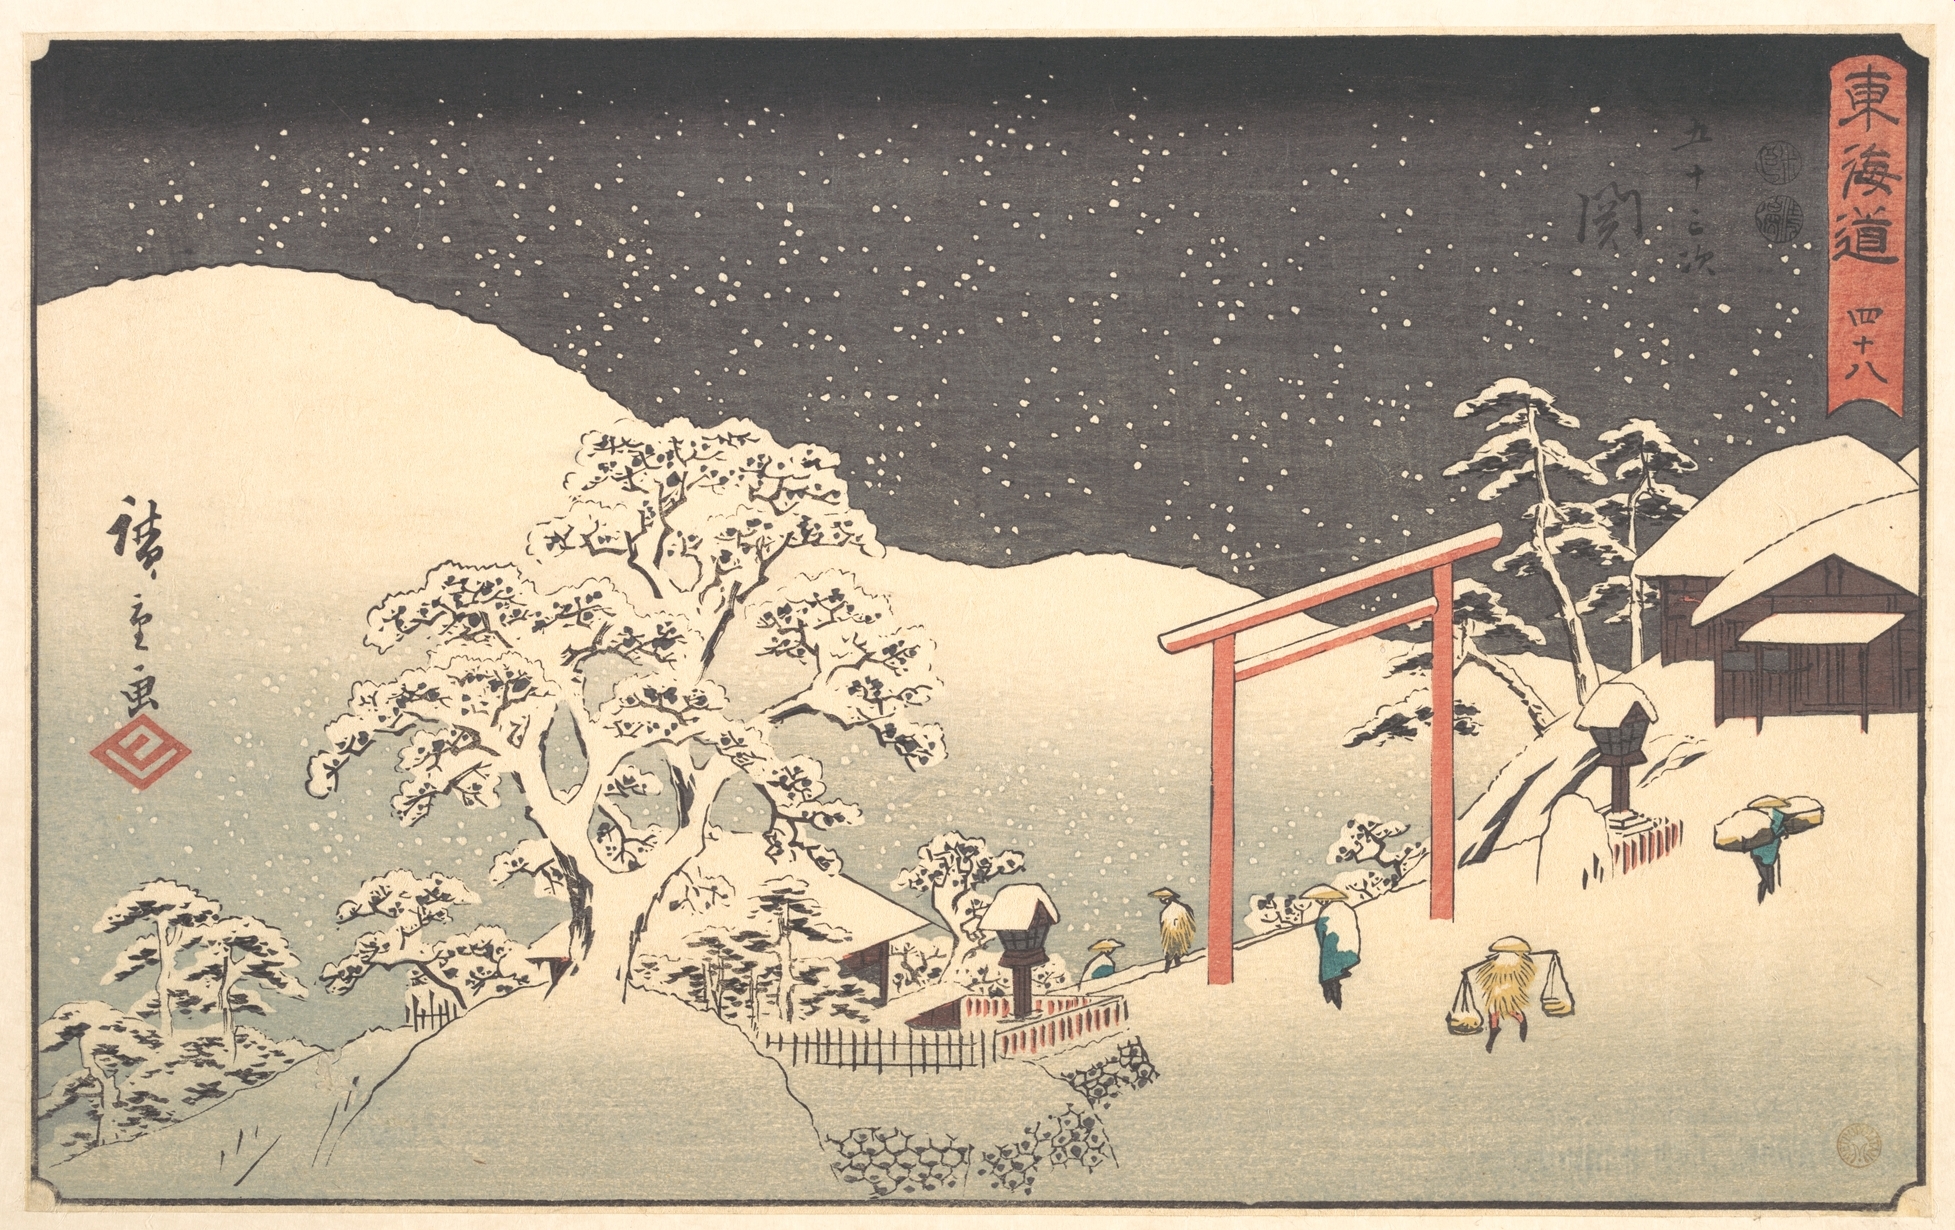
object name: print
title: Seki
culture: japanese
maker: utagawa hiroshige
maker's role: artist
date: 1848-1849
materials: ink, paper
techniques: woodblock print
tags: gates,landscapes,trees,snow